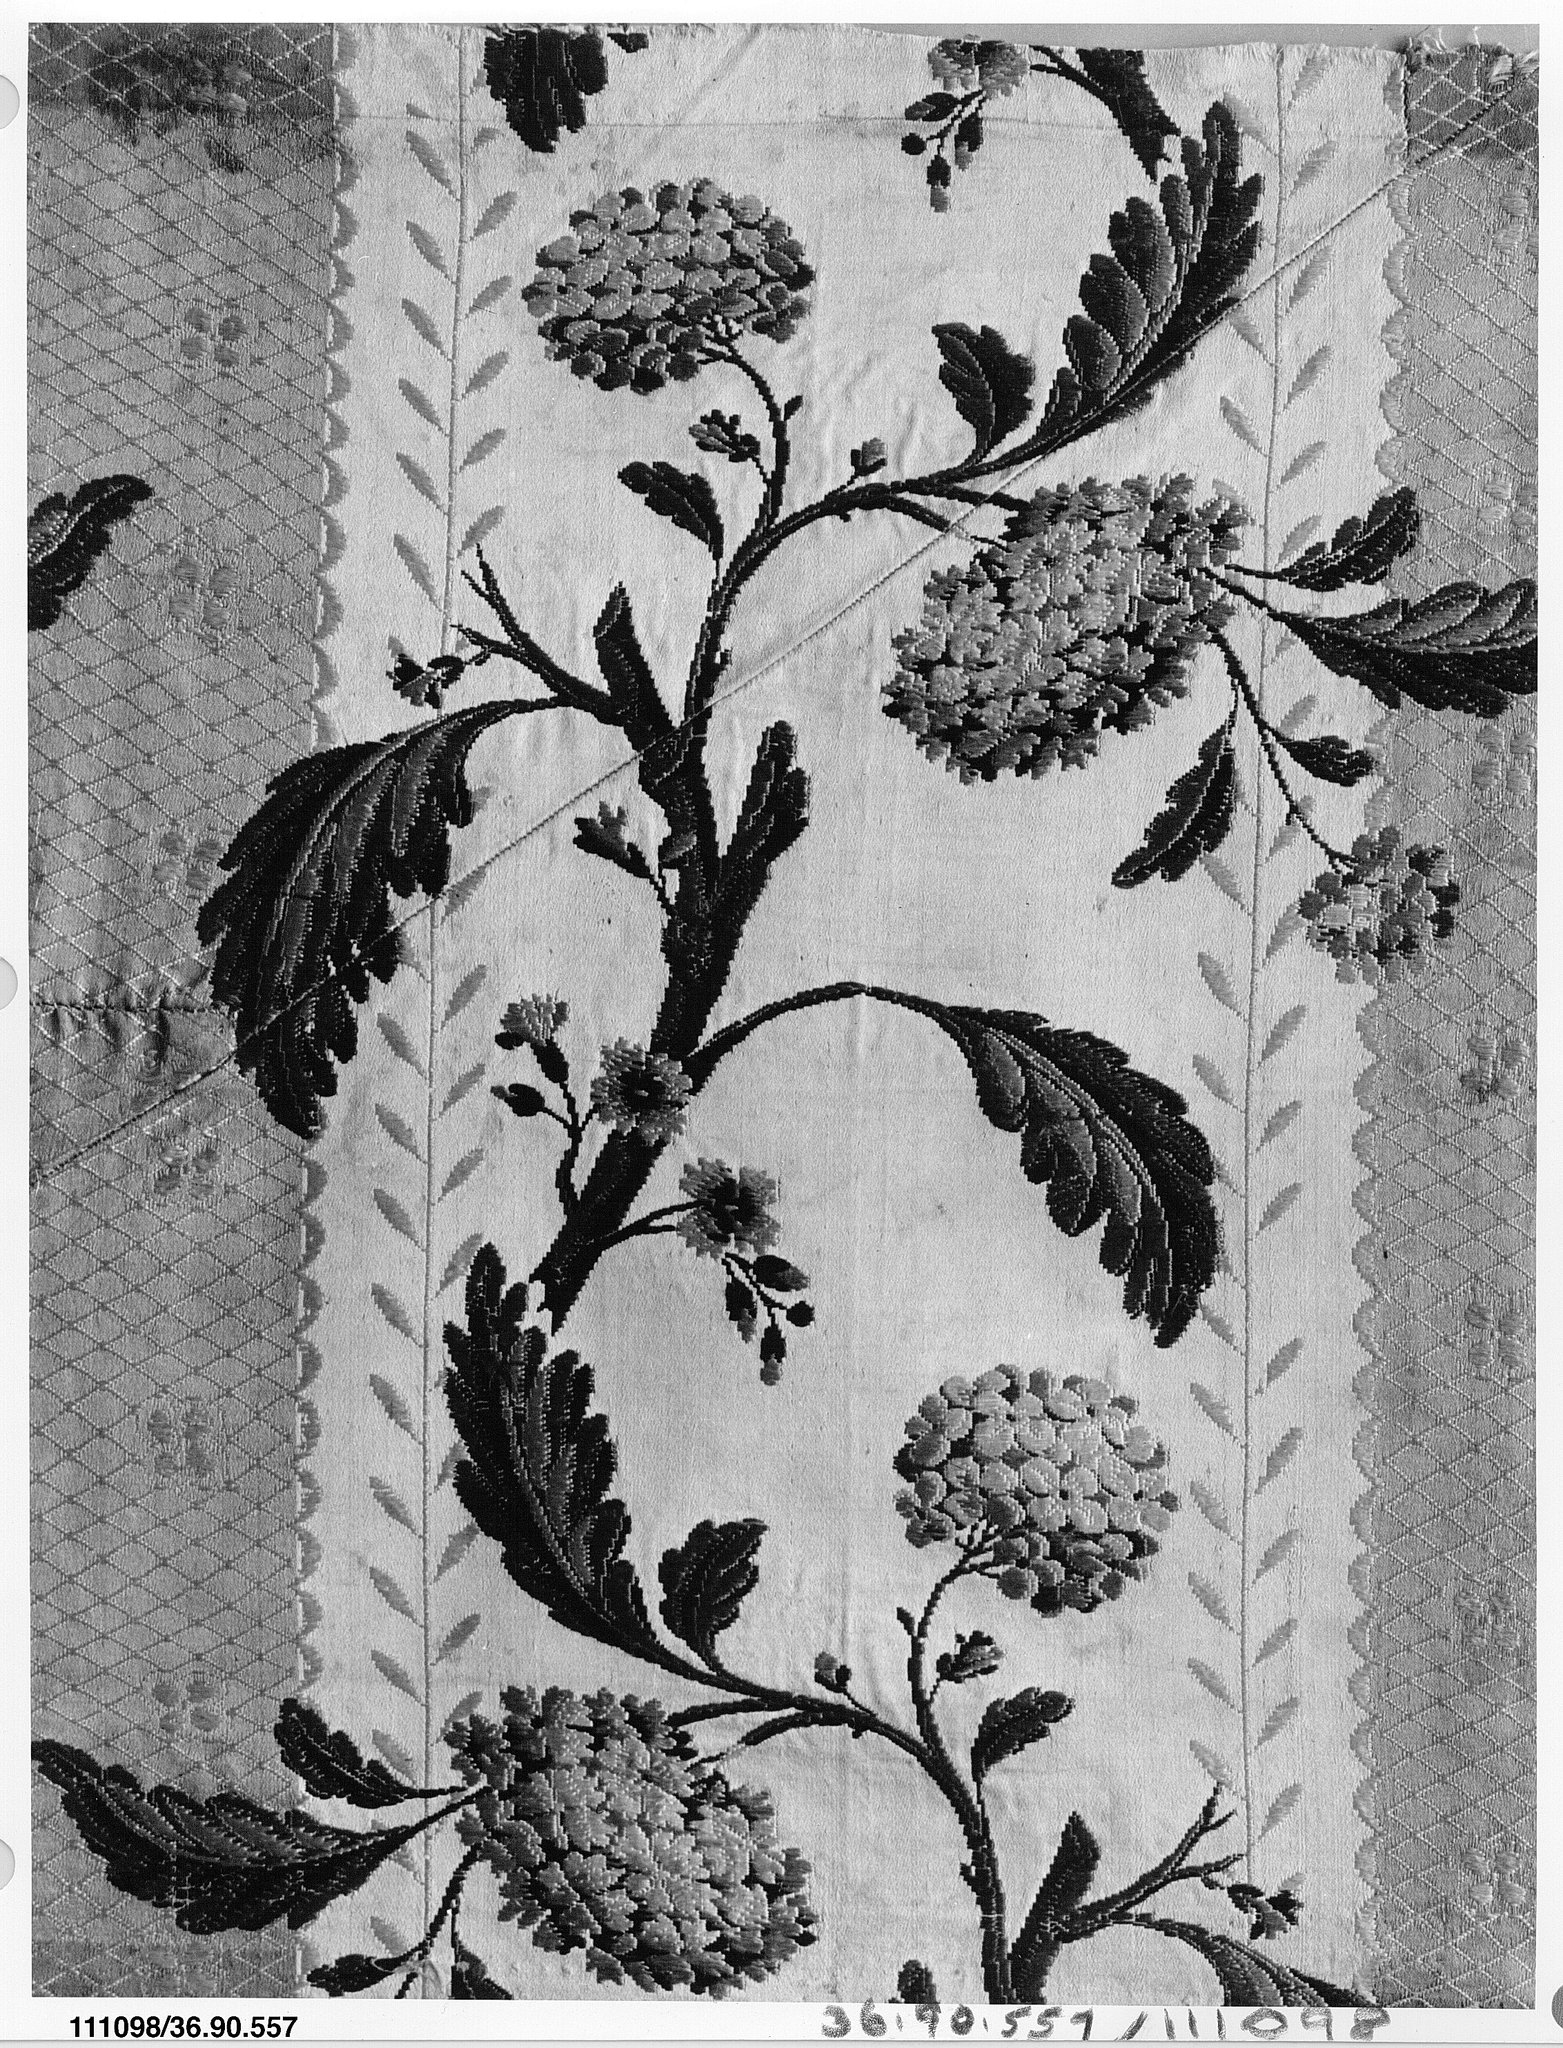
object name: piece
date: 1767-1800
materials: silk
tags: flowers,leaves